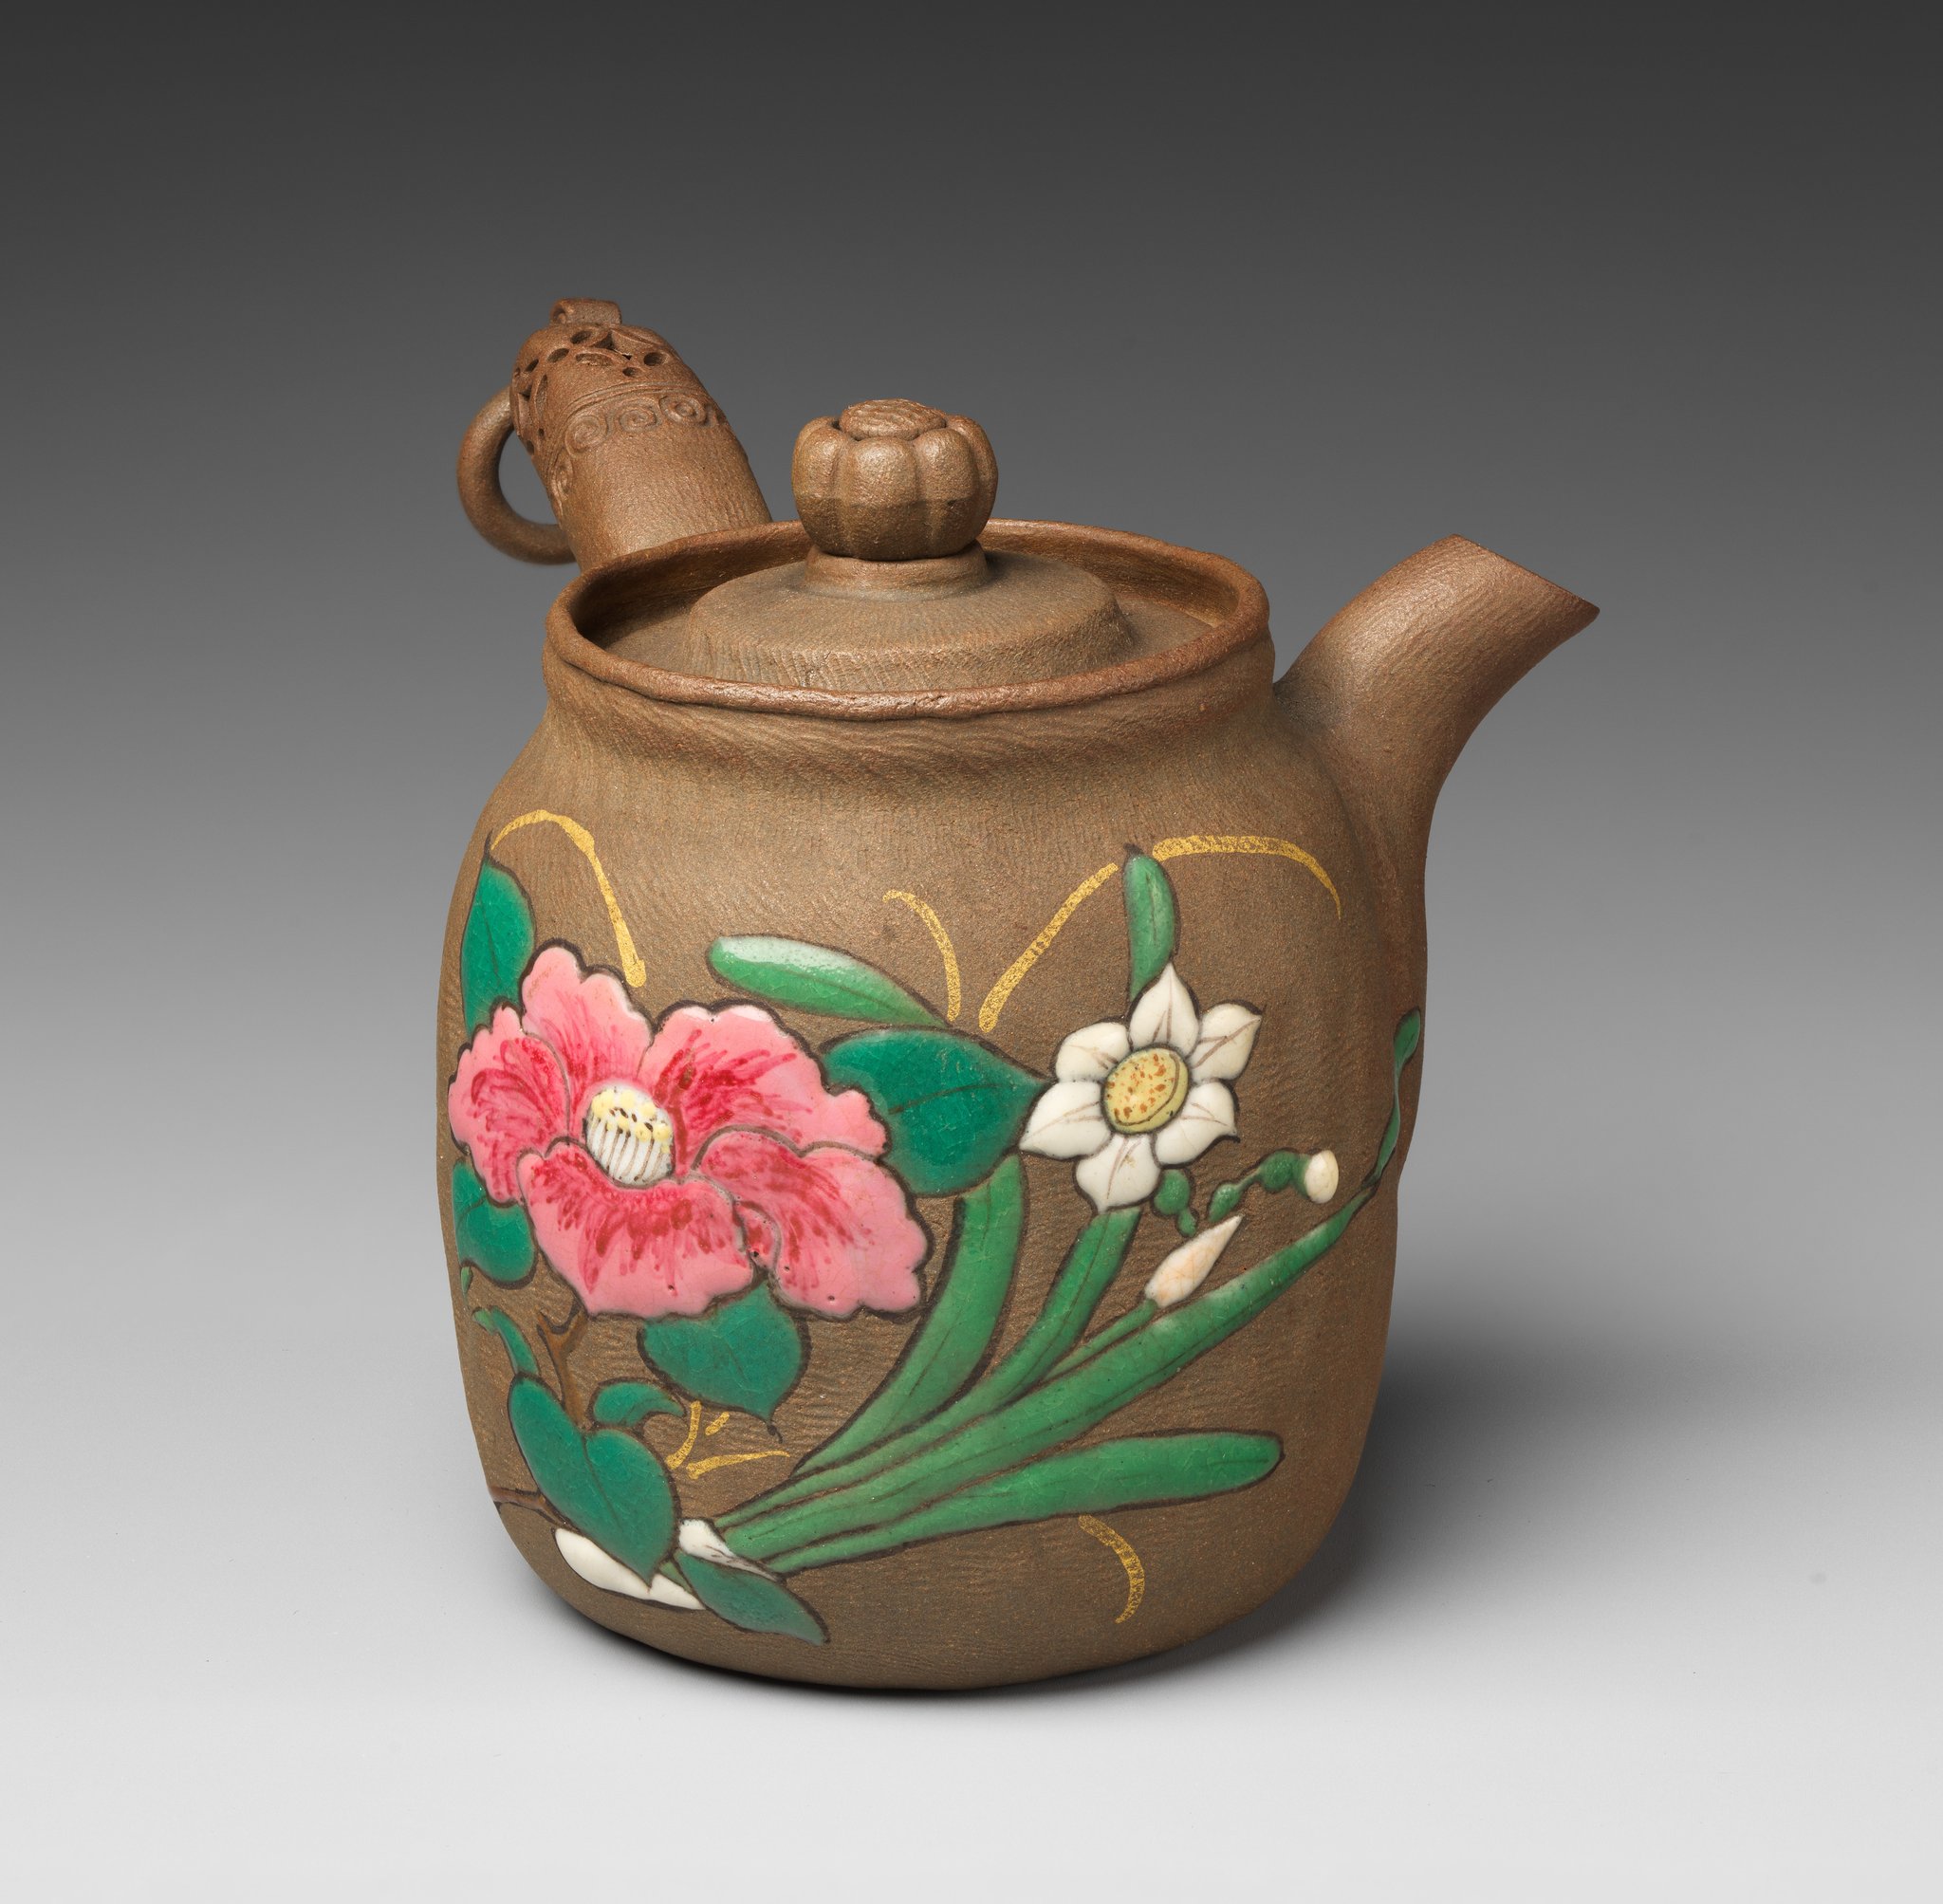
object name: teapot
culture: japanese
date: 1801-1833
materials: enamel, pottery